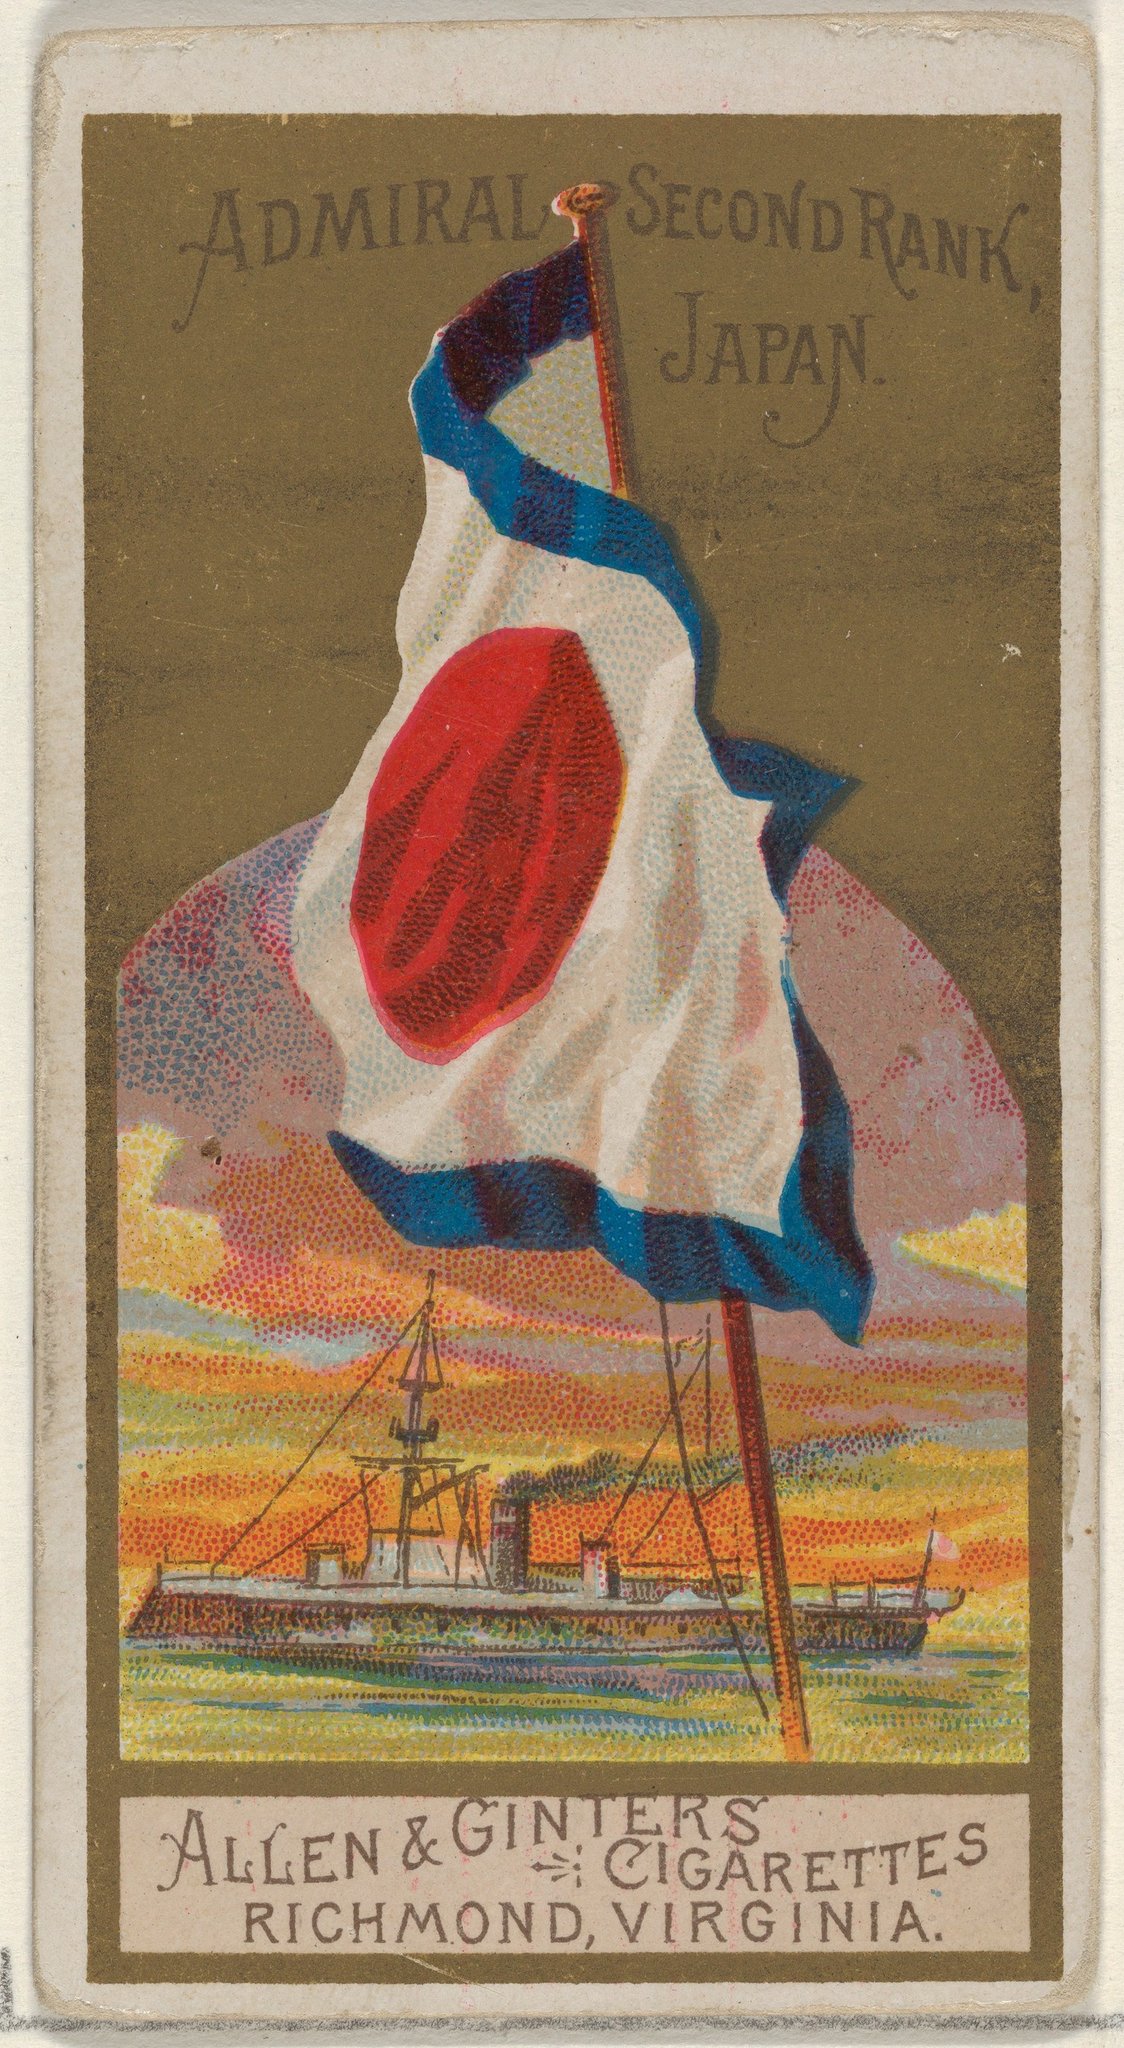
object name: print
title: Admiral Second Rank, Japan, from the Naval Flags series (N17) for Allen & Ginter Cigarettes Brands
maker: allen & ginter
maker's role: publisher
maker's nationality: american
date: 1888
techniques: color lithograph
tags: flags